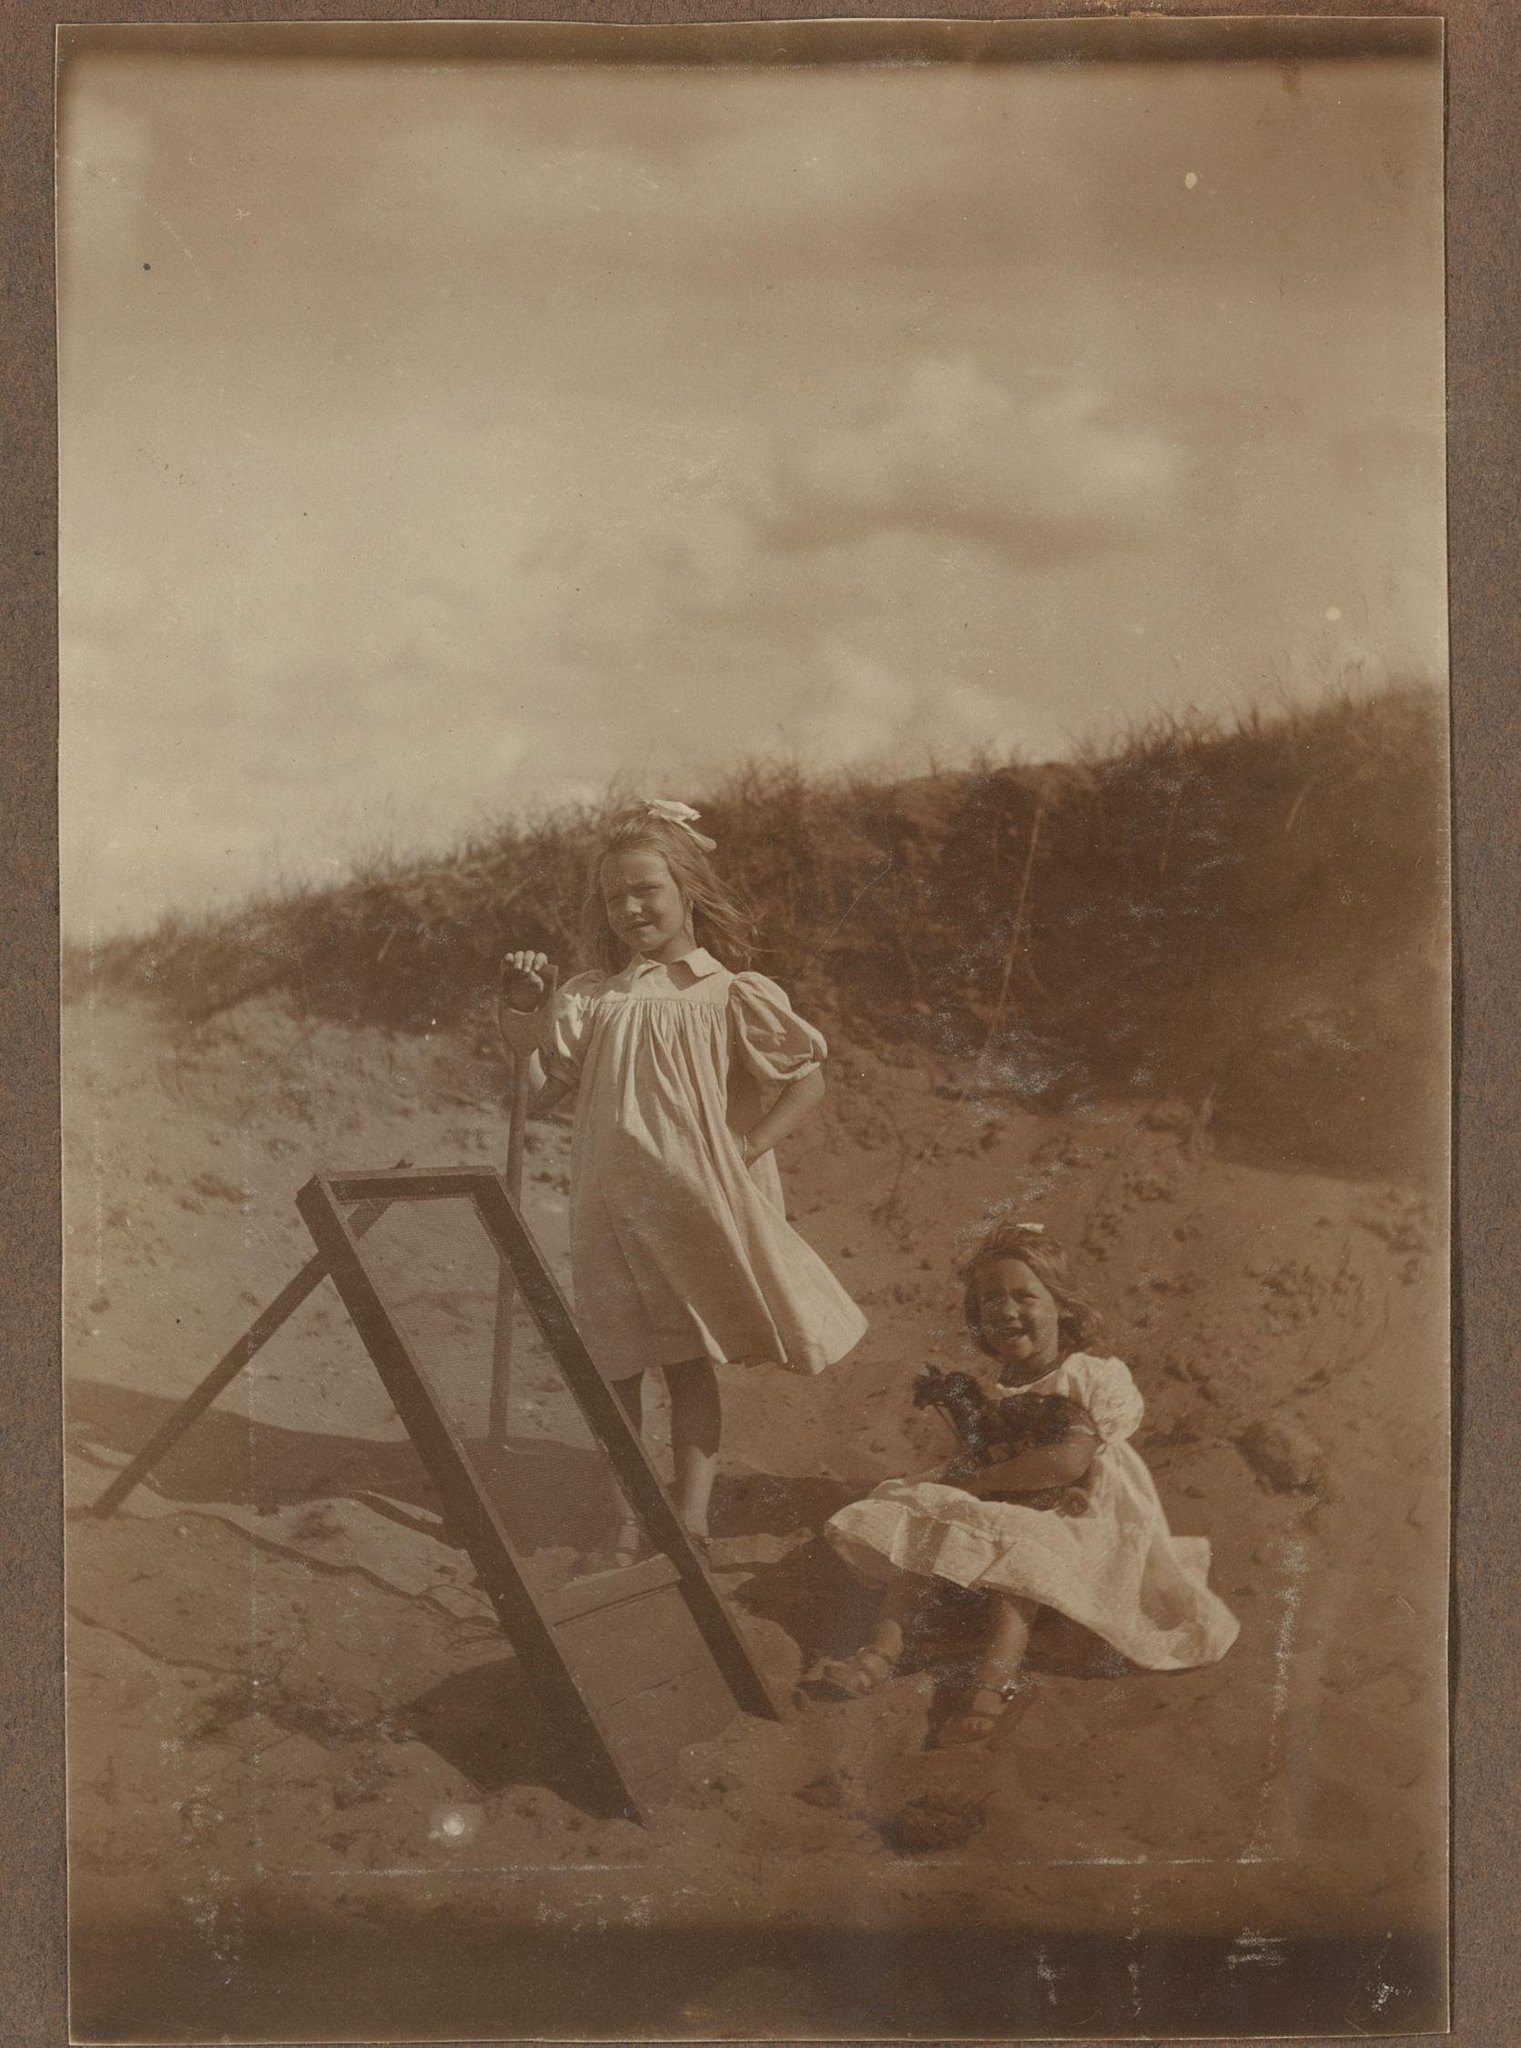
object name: photograph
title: Joanna en Thea Diepenbrock op de heide bij Laren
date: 1911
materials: photographic support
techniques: photography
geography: amsterdam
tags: amsterdam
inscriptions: inscription: ‘1911. / Larensche heide’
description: Foto op bruin albumblad 18 van familiealbum van Alphons Diepenbrock.